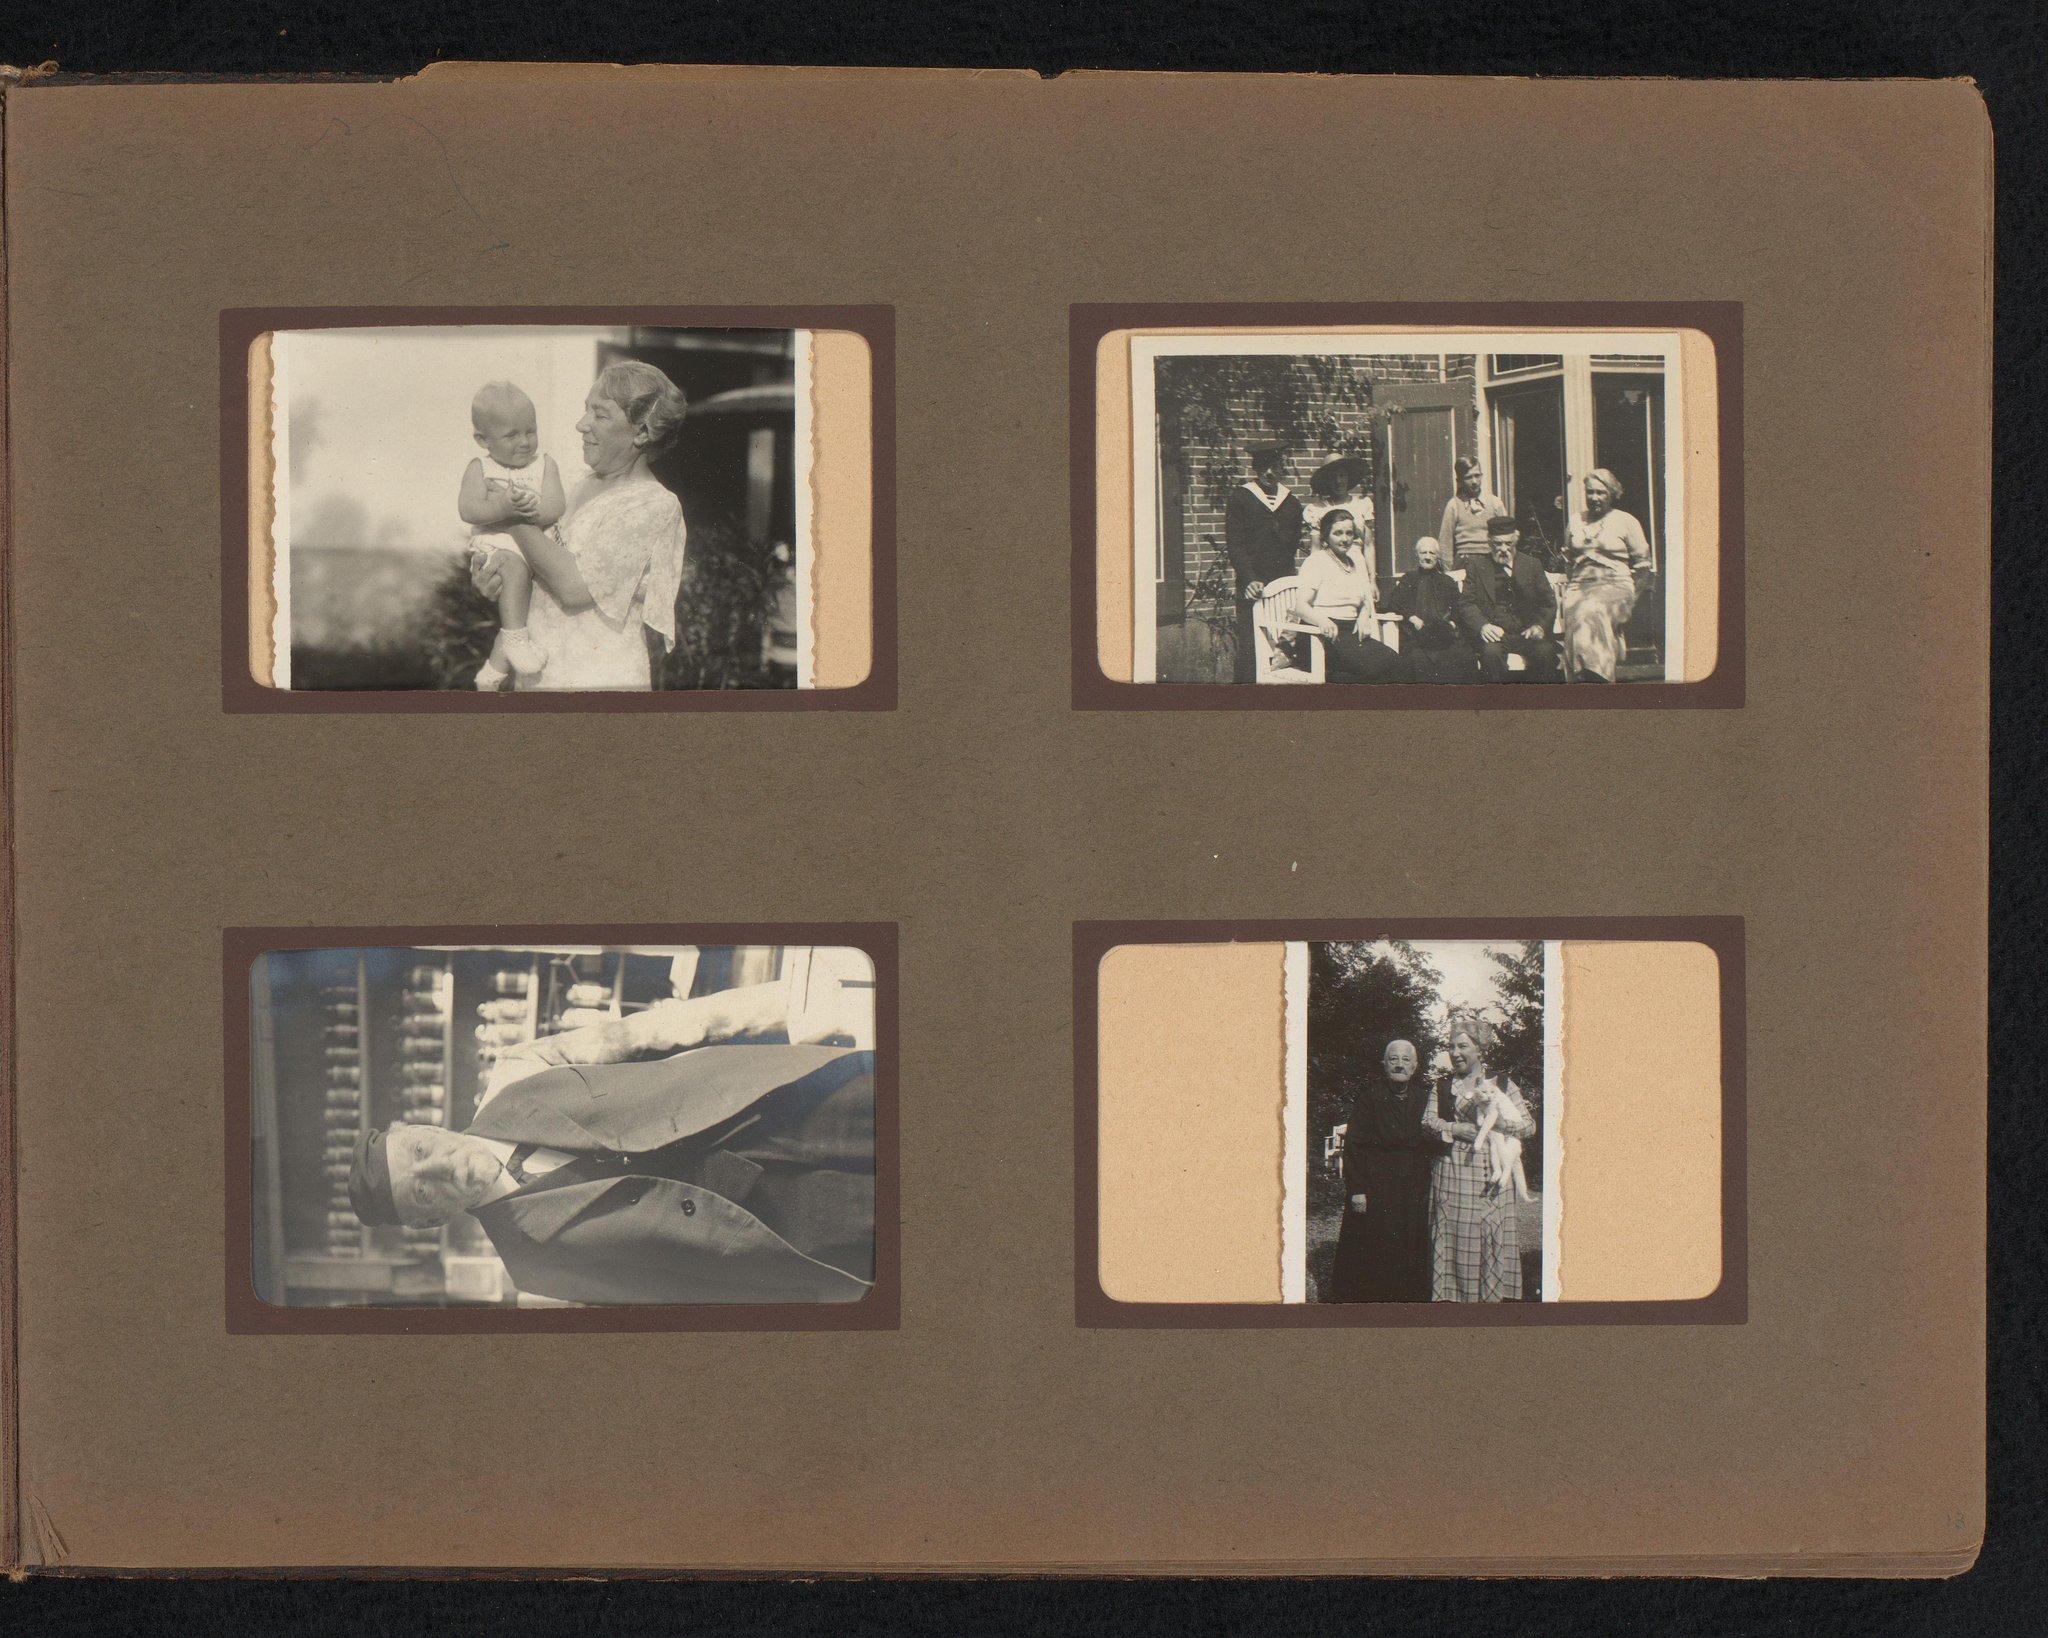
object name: album leaf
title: Vier foto's van de familie Bon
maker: Anonymous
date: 1920-1940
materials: paper, cardboard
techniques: gelatin silver print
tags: amsterdam, family group, especially parents with their child(ren), child, historical persons, historical persons not known by name, netherlands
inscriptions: inscription: ‘grootvader/ P.H. Bon/ in zijn/ leerapotheek’, inscription: ‘19 Januari 1936/ Hij doet net "klap/ maar in je handjes./ Voor Casper en Jet.’, number: ‘523’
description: Deze foto's maken deel uit van een album.